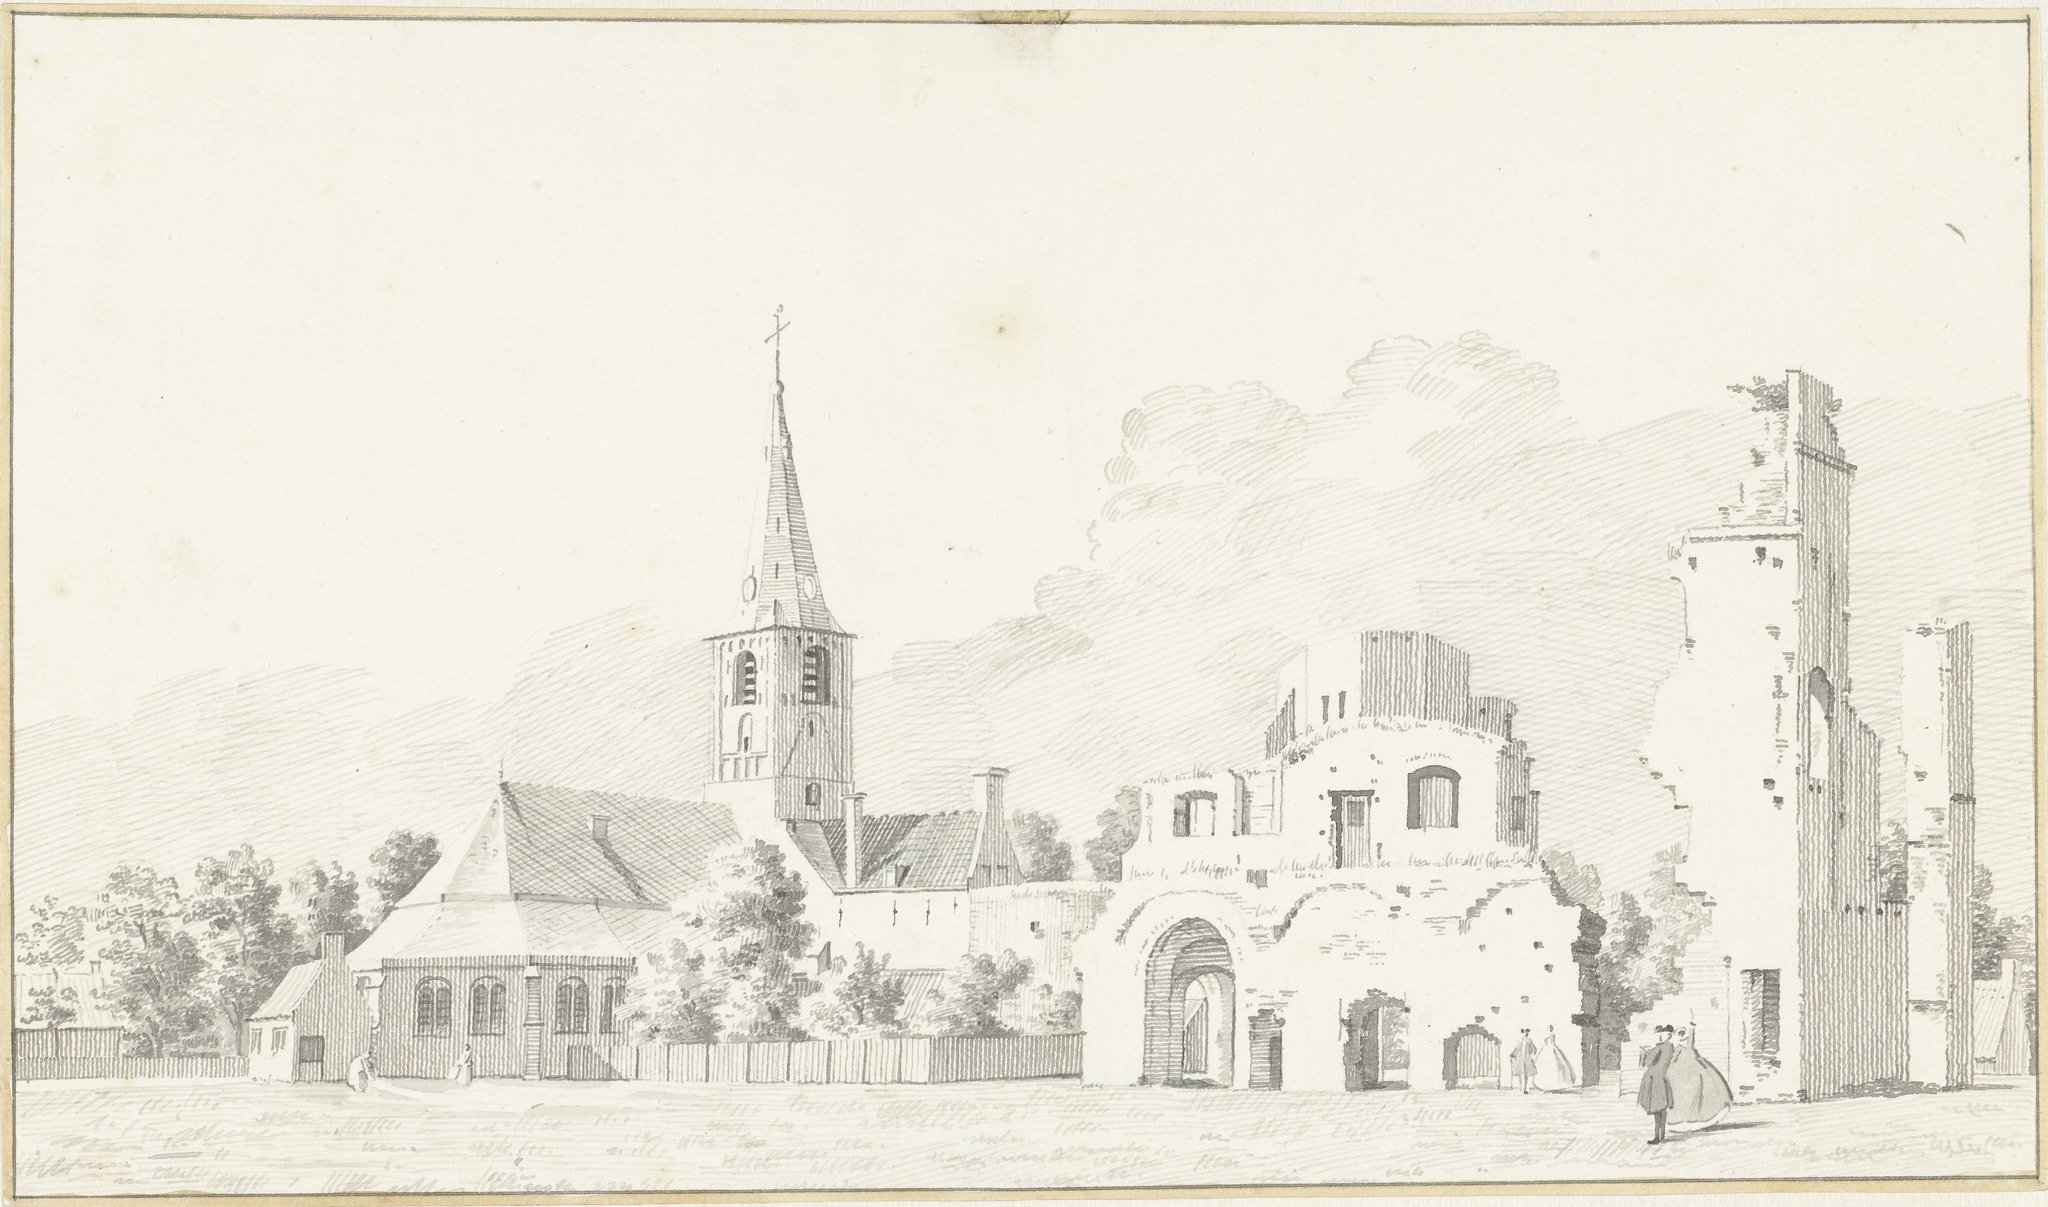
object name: drawing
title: Kerk en de ruïne van de abdij van Rijnsburg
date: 1727-1790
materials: ink, paper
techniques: brush, pen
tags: ruin of church, monastery, etc.